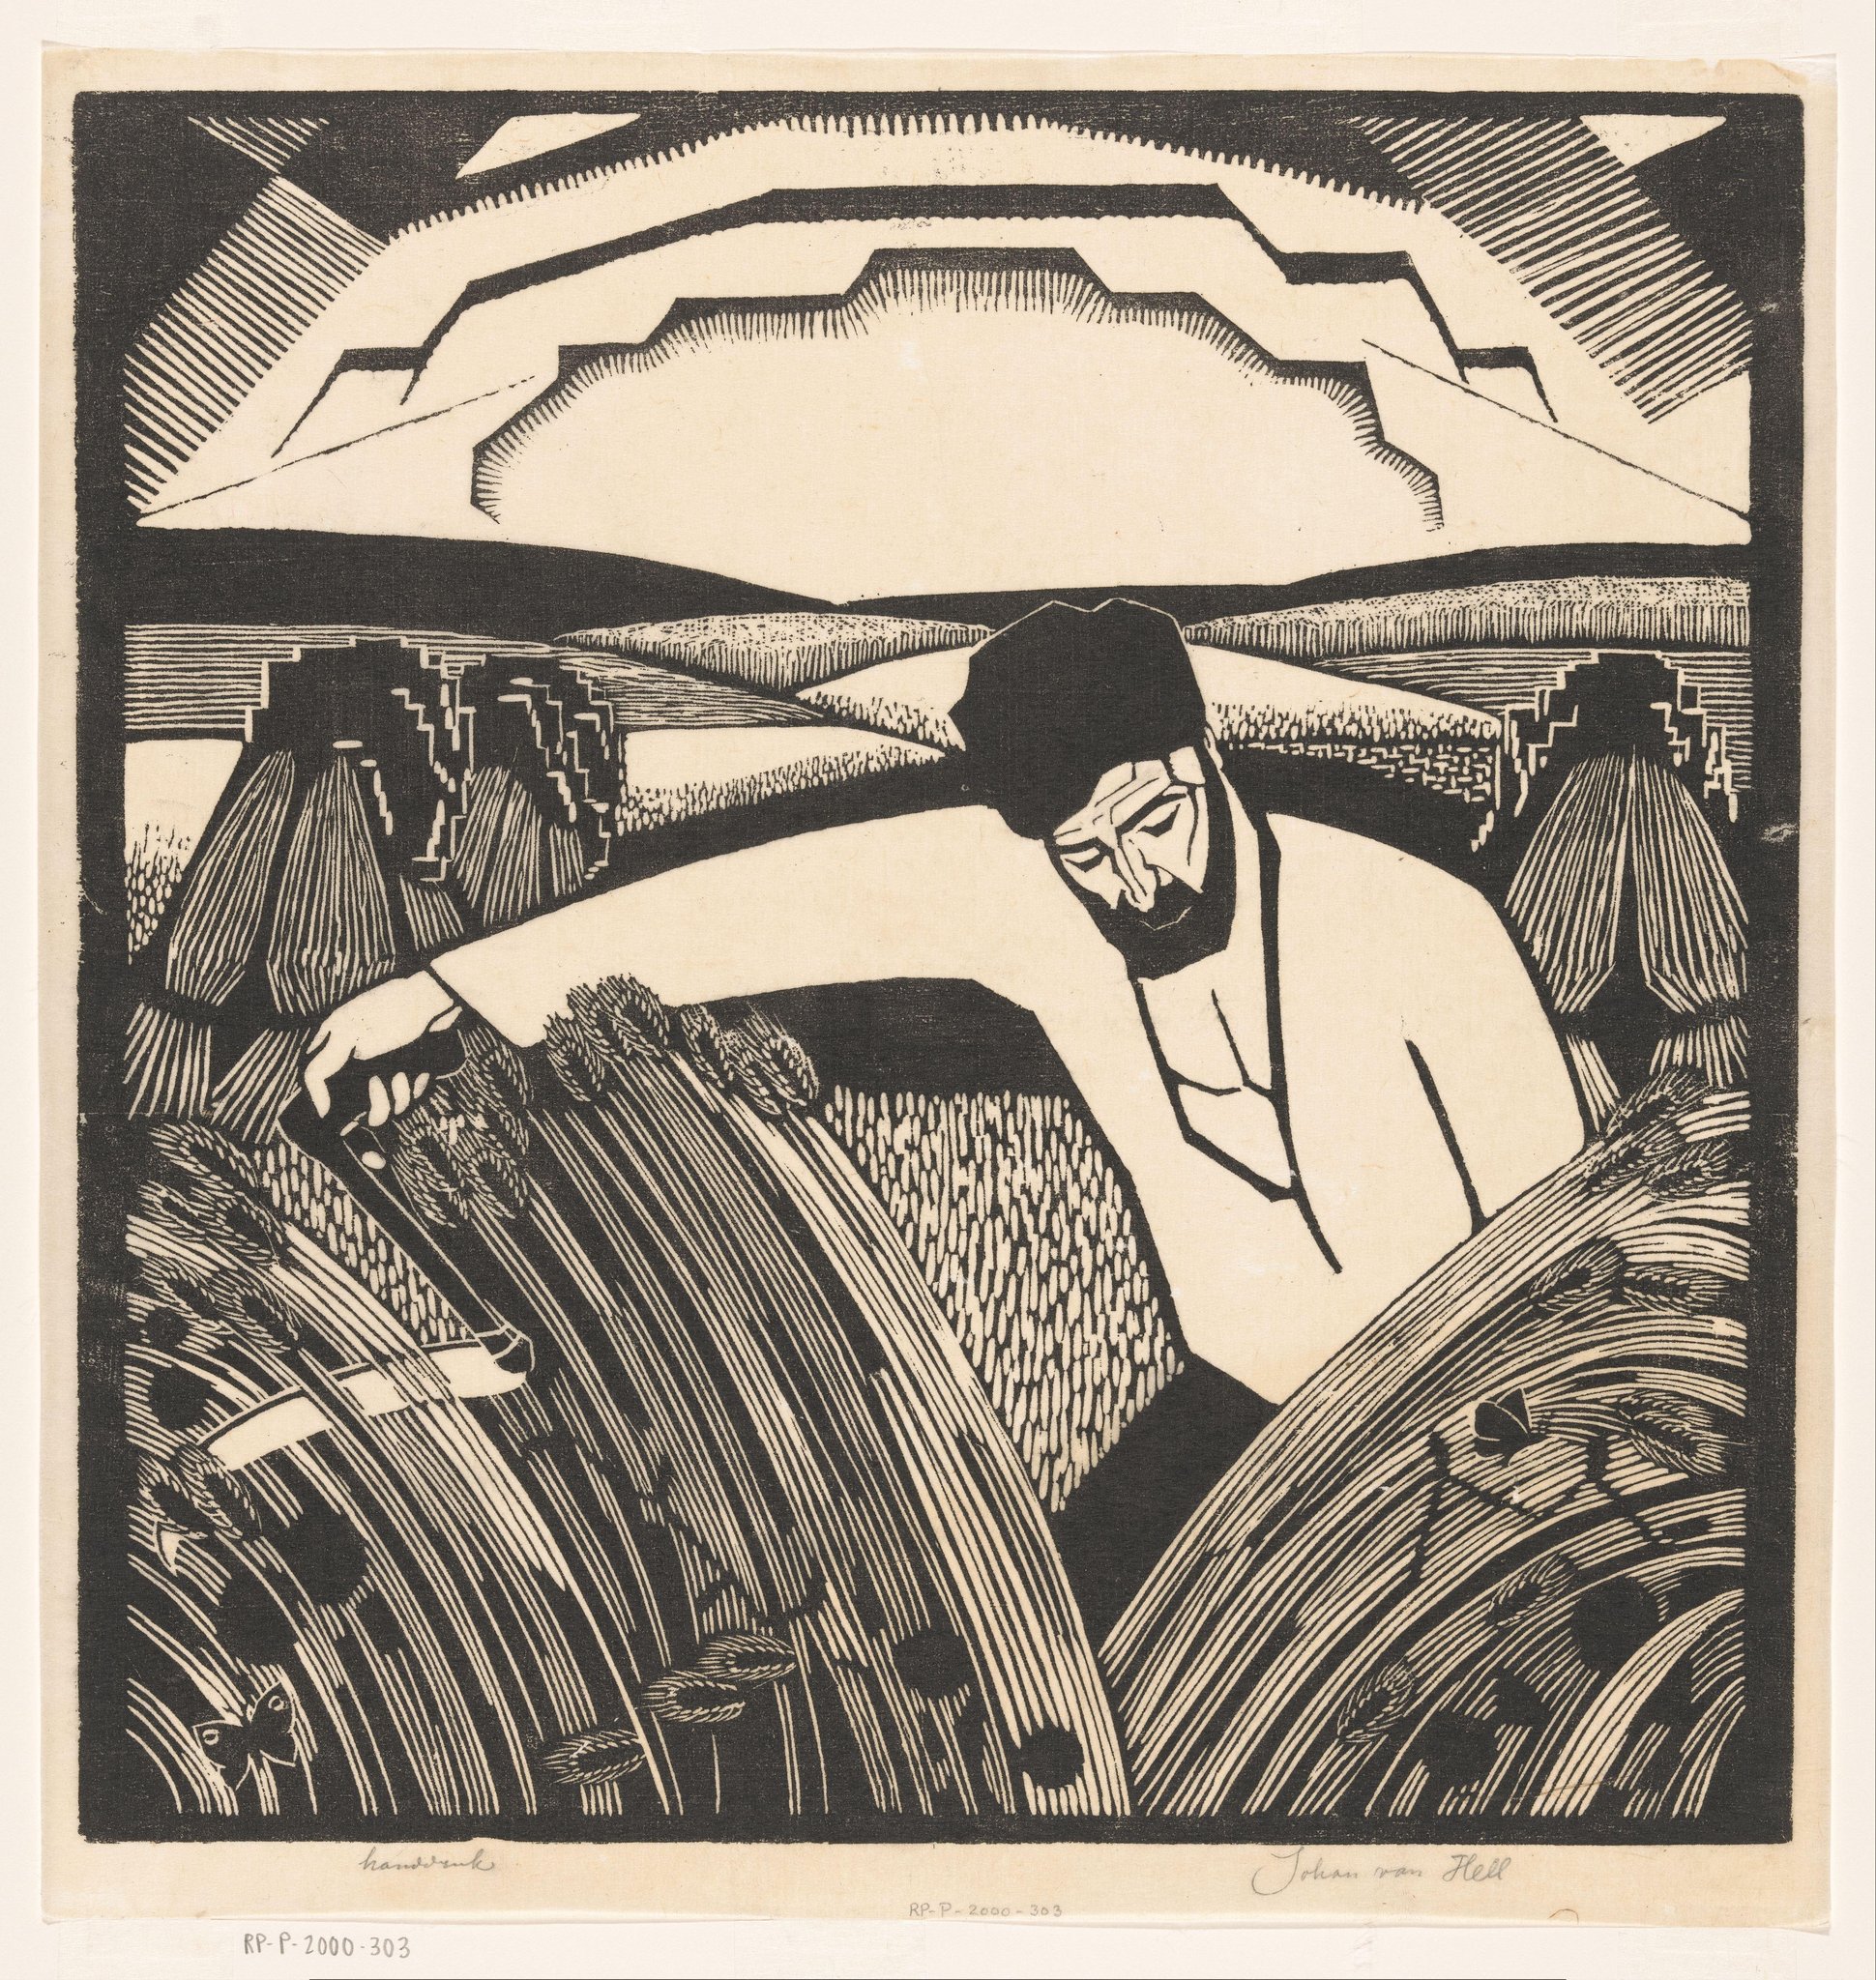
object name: print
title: Boer die graan oogst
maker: johan van hell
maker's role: print maker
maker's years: 1889-1952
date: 1921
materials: paper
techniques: woodcut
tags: harvest, farmers, cereal, grain, corn (grass with grains, grown for food, e.g.: wheat, rice, rye, oats, maize, buckwheat, millet)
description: Een bebaarde man maait graan met zijn zeis. Op de achtergrond een glooiend landschap met graanvelden die zich tot de horizon uitstrekken.